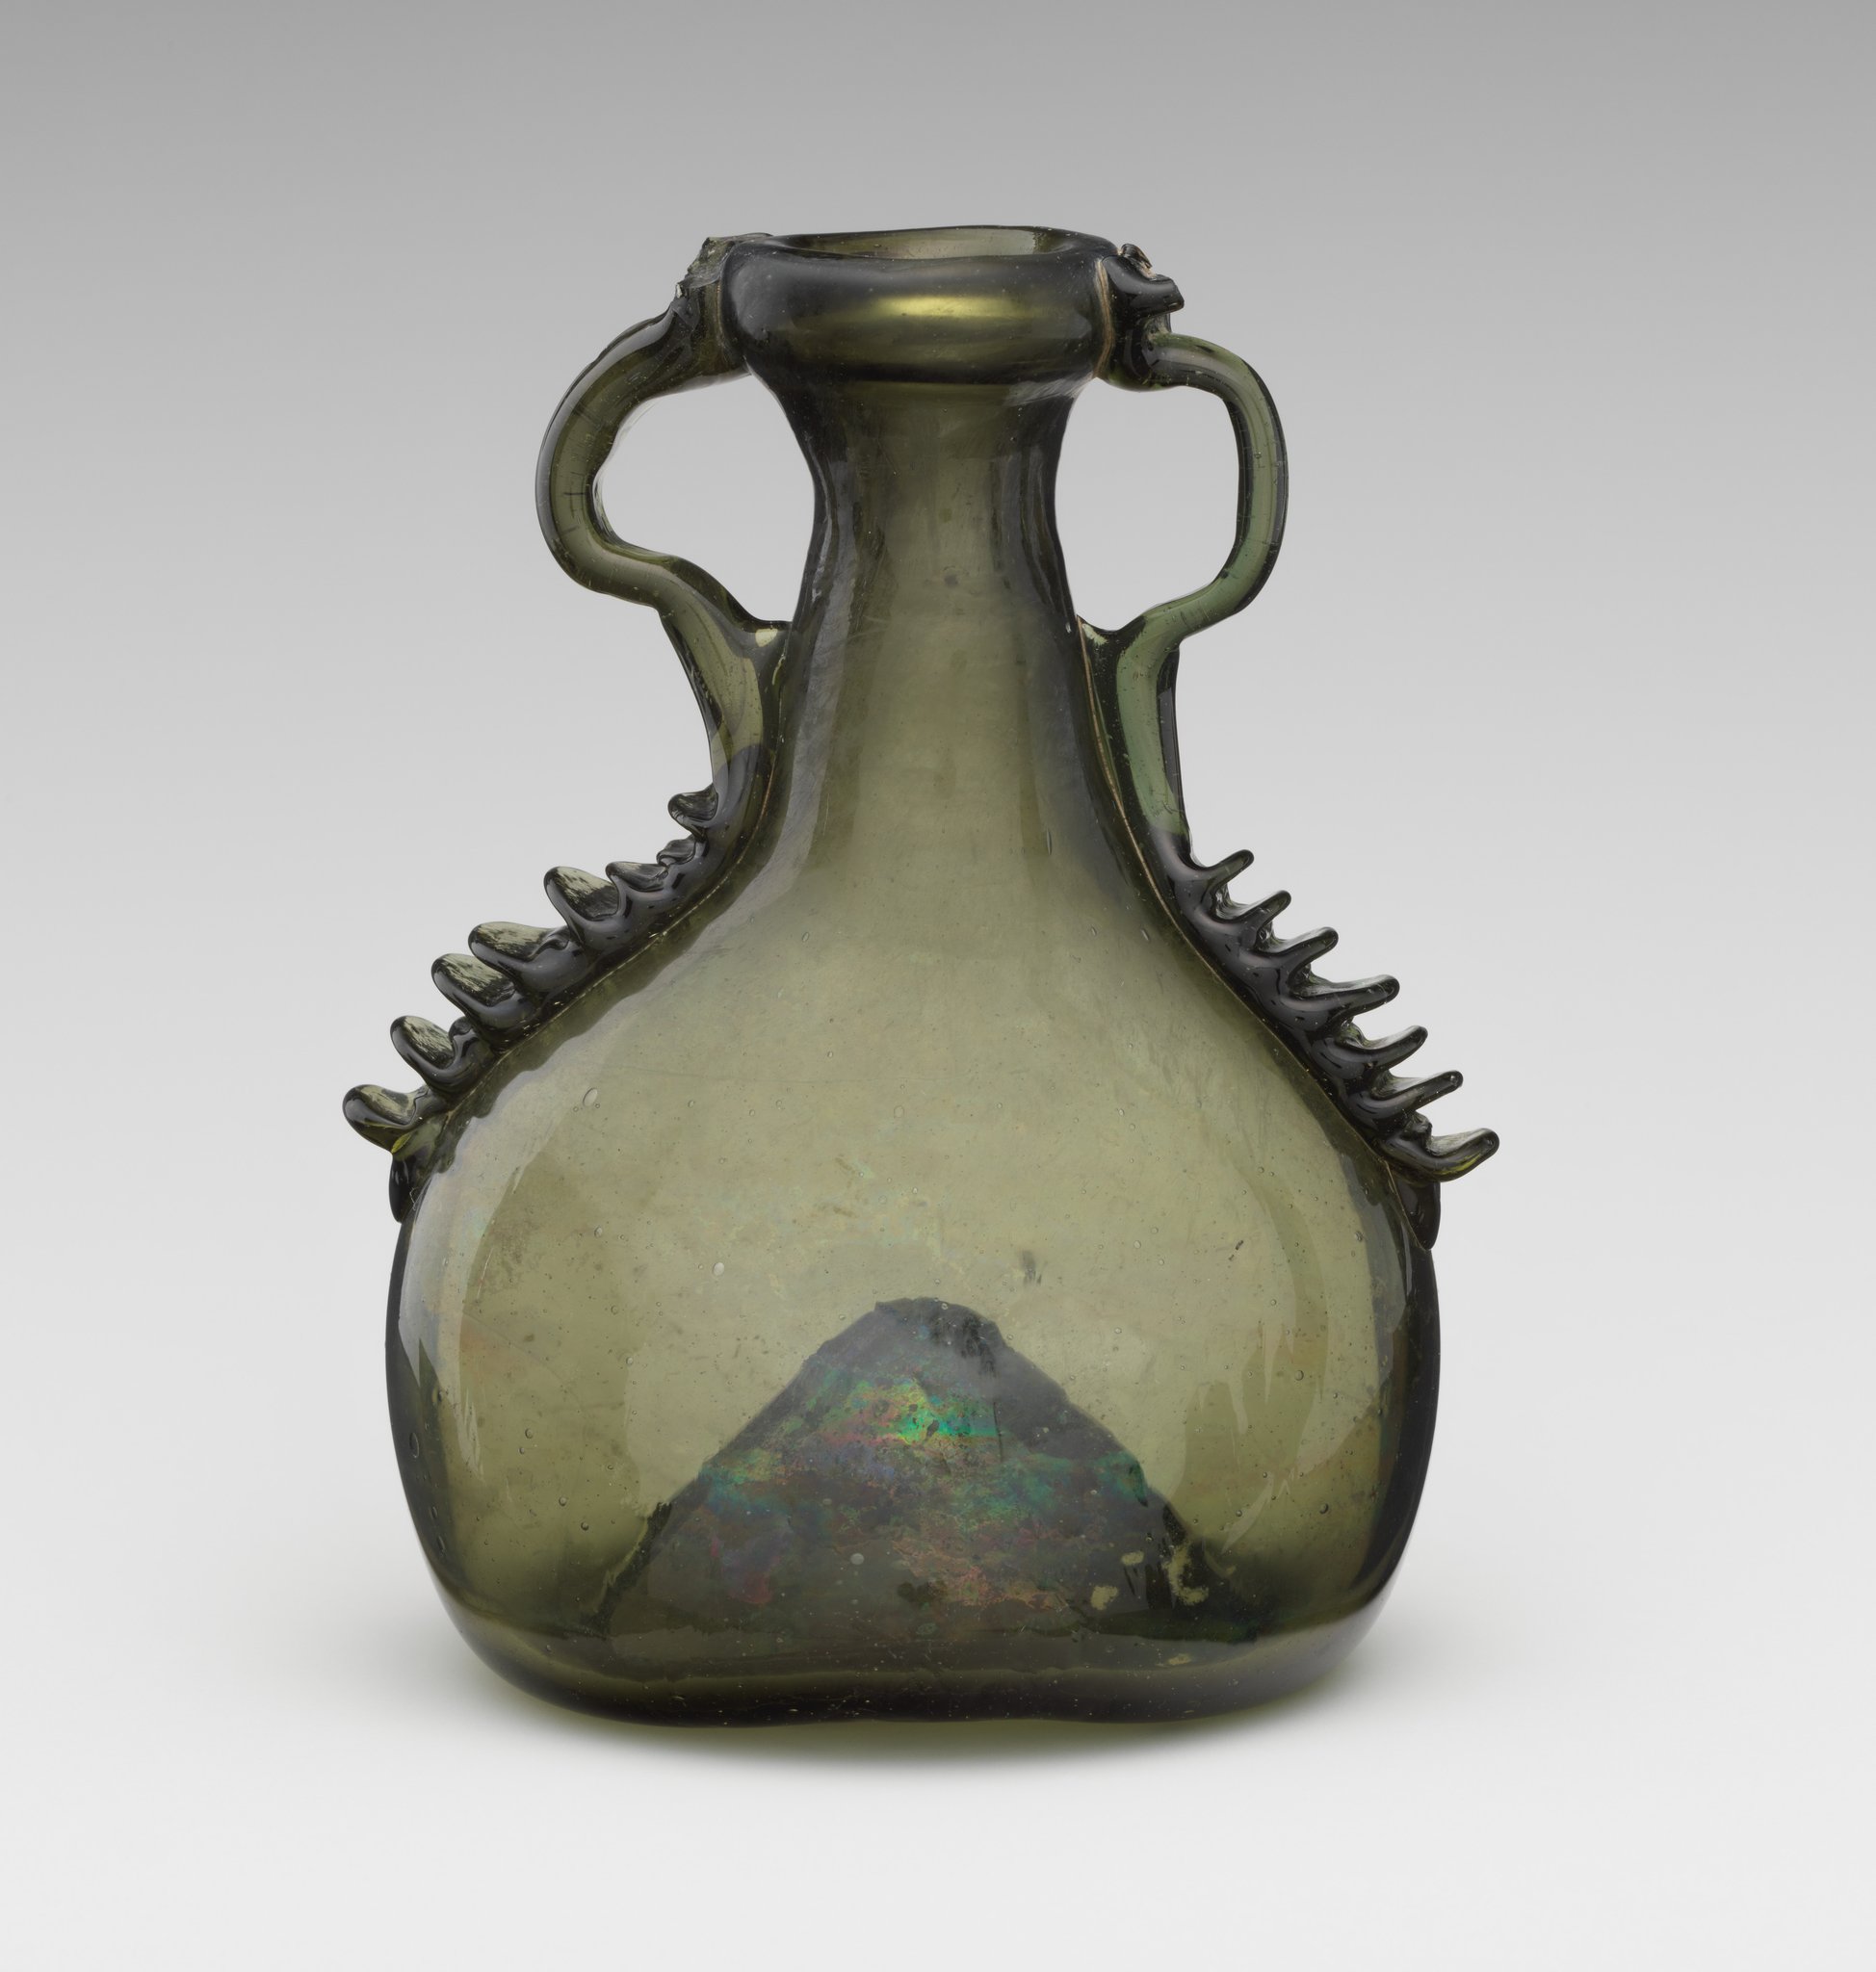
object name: bottle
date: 1601-1700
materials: glass